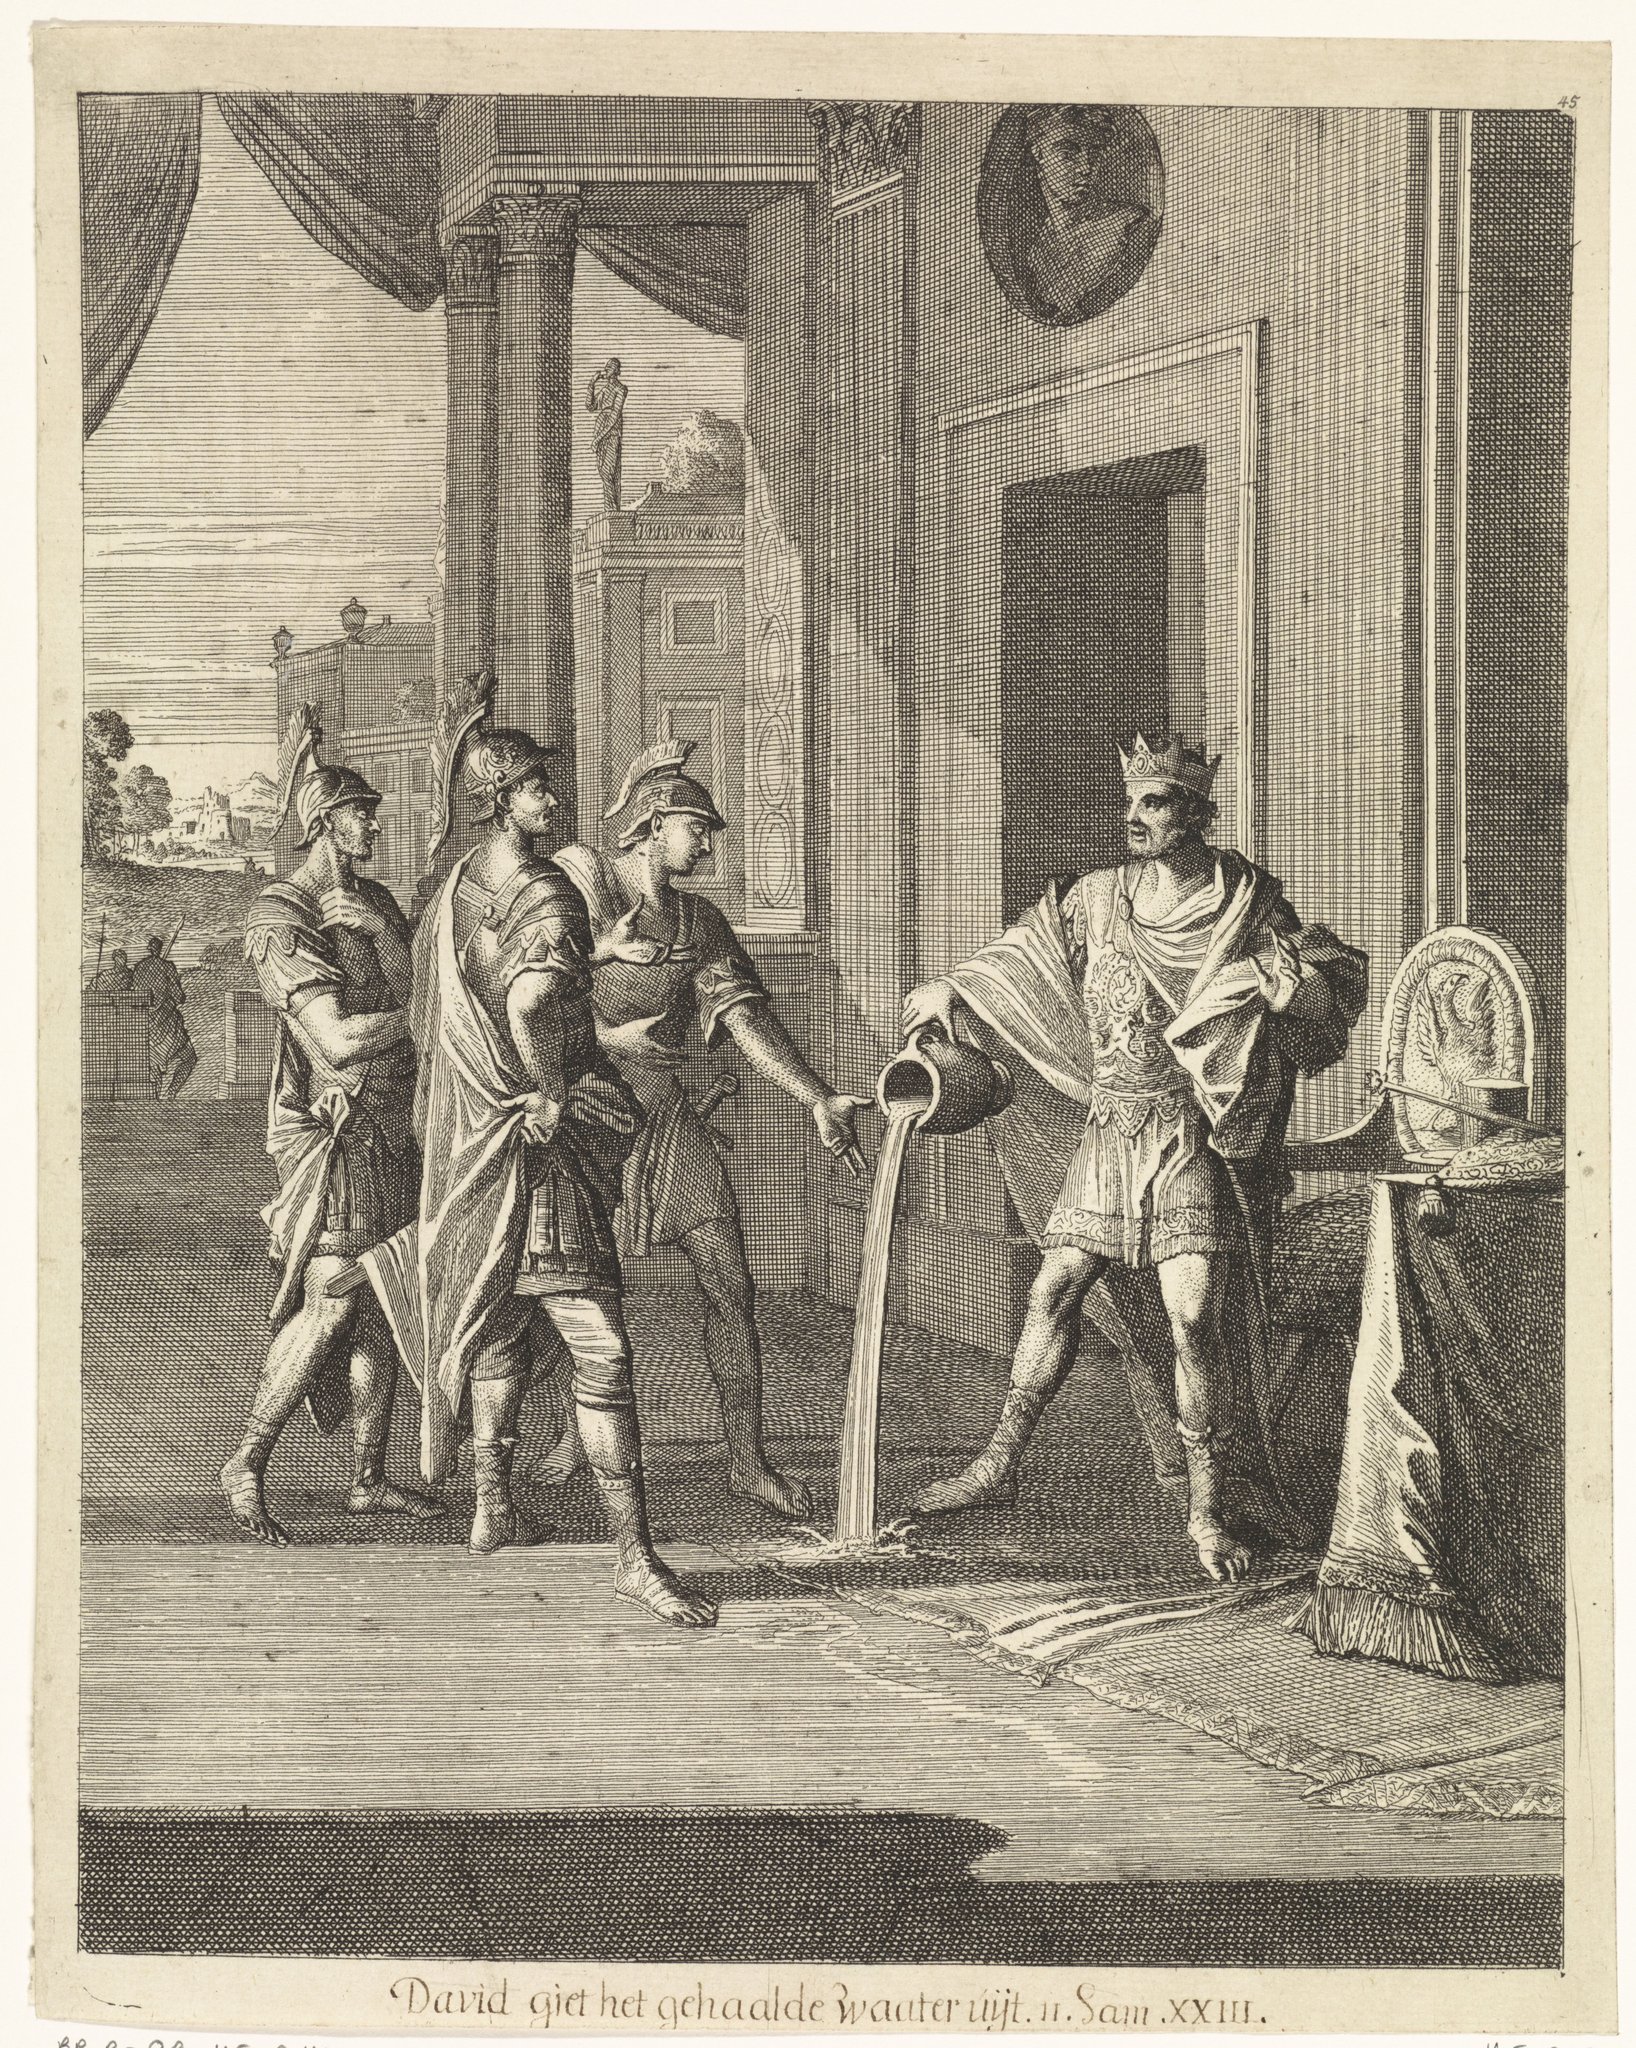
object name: print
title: David giet het water uit de waterput te Betlehem uit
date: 1708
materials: paper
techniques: etching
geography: nuremberg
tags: three of david's heroes draw water out of the well of bethlehem, during their stay in the cave adullam; david pours the water out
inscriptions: collector's mark: Lugt 2228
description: Proefdruk van een prent welke is opgenomen als illustratie in: Historiae Celebriores Veteris Testamenti. Christoph Weigel, 1708.